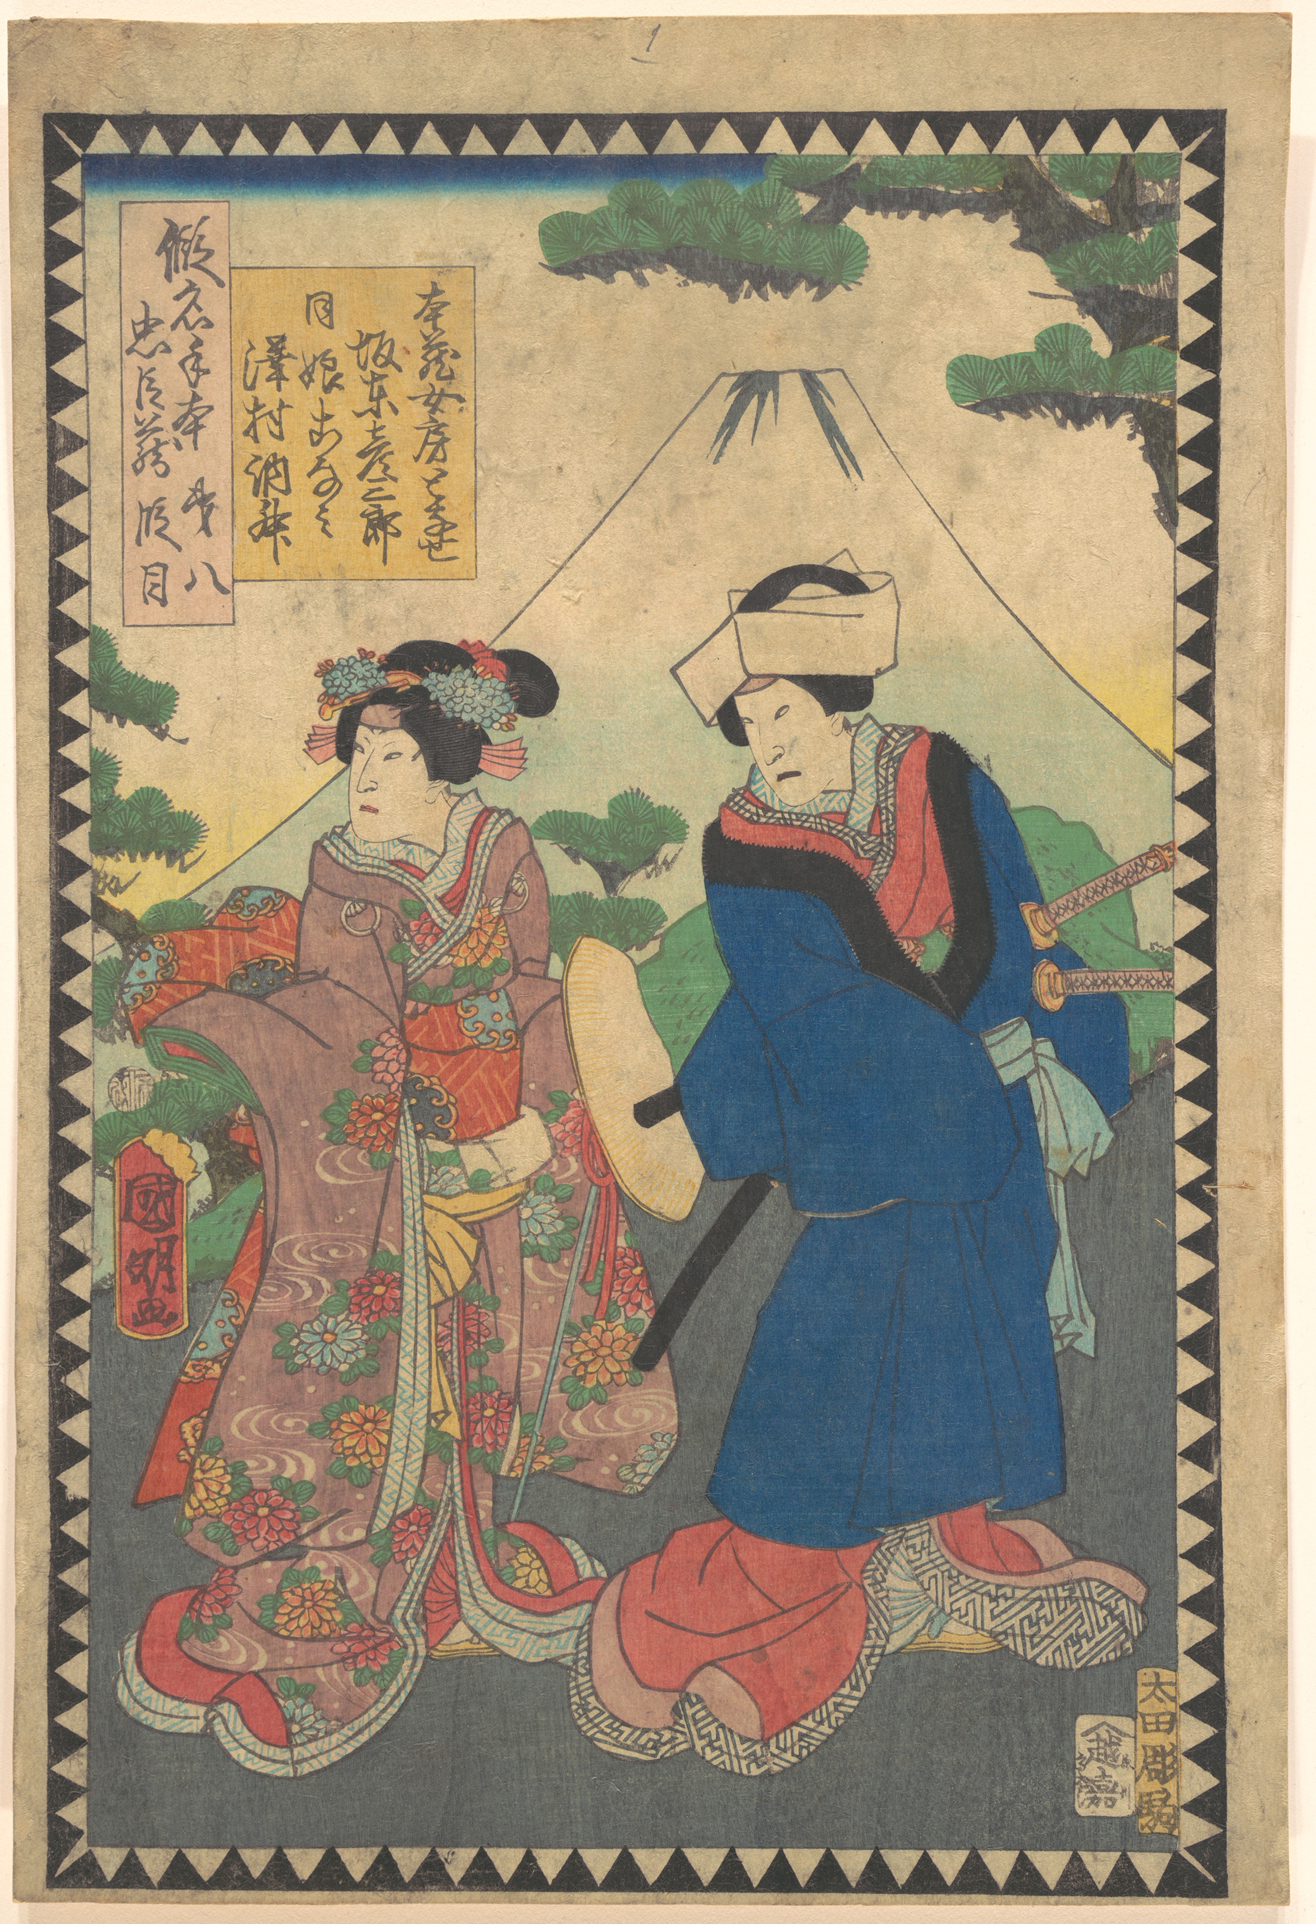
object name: print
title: Act VIII (Dai hachidanme): Actors Bandō Hikosaburō V as Honzō's Wife (Nyōbō) Tonase and Sawamura Tosshō II as His Daughter (Musume) Konami, from the series The Storehouse of Loyal Retainers, a Primer (Kanadehon chūshingura)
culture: japanese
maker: utagawa kuniaki ii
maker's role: artist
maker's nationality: japanese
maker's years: 1835-1888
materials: ink, paper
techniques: woodblock print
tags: men,women,actors